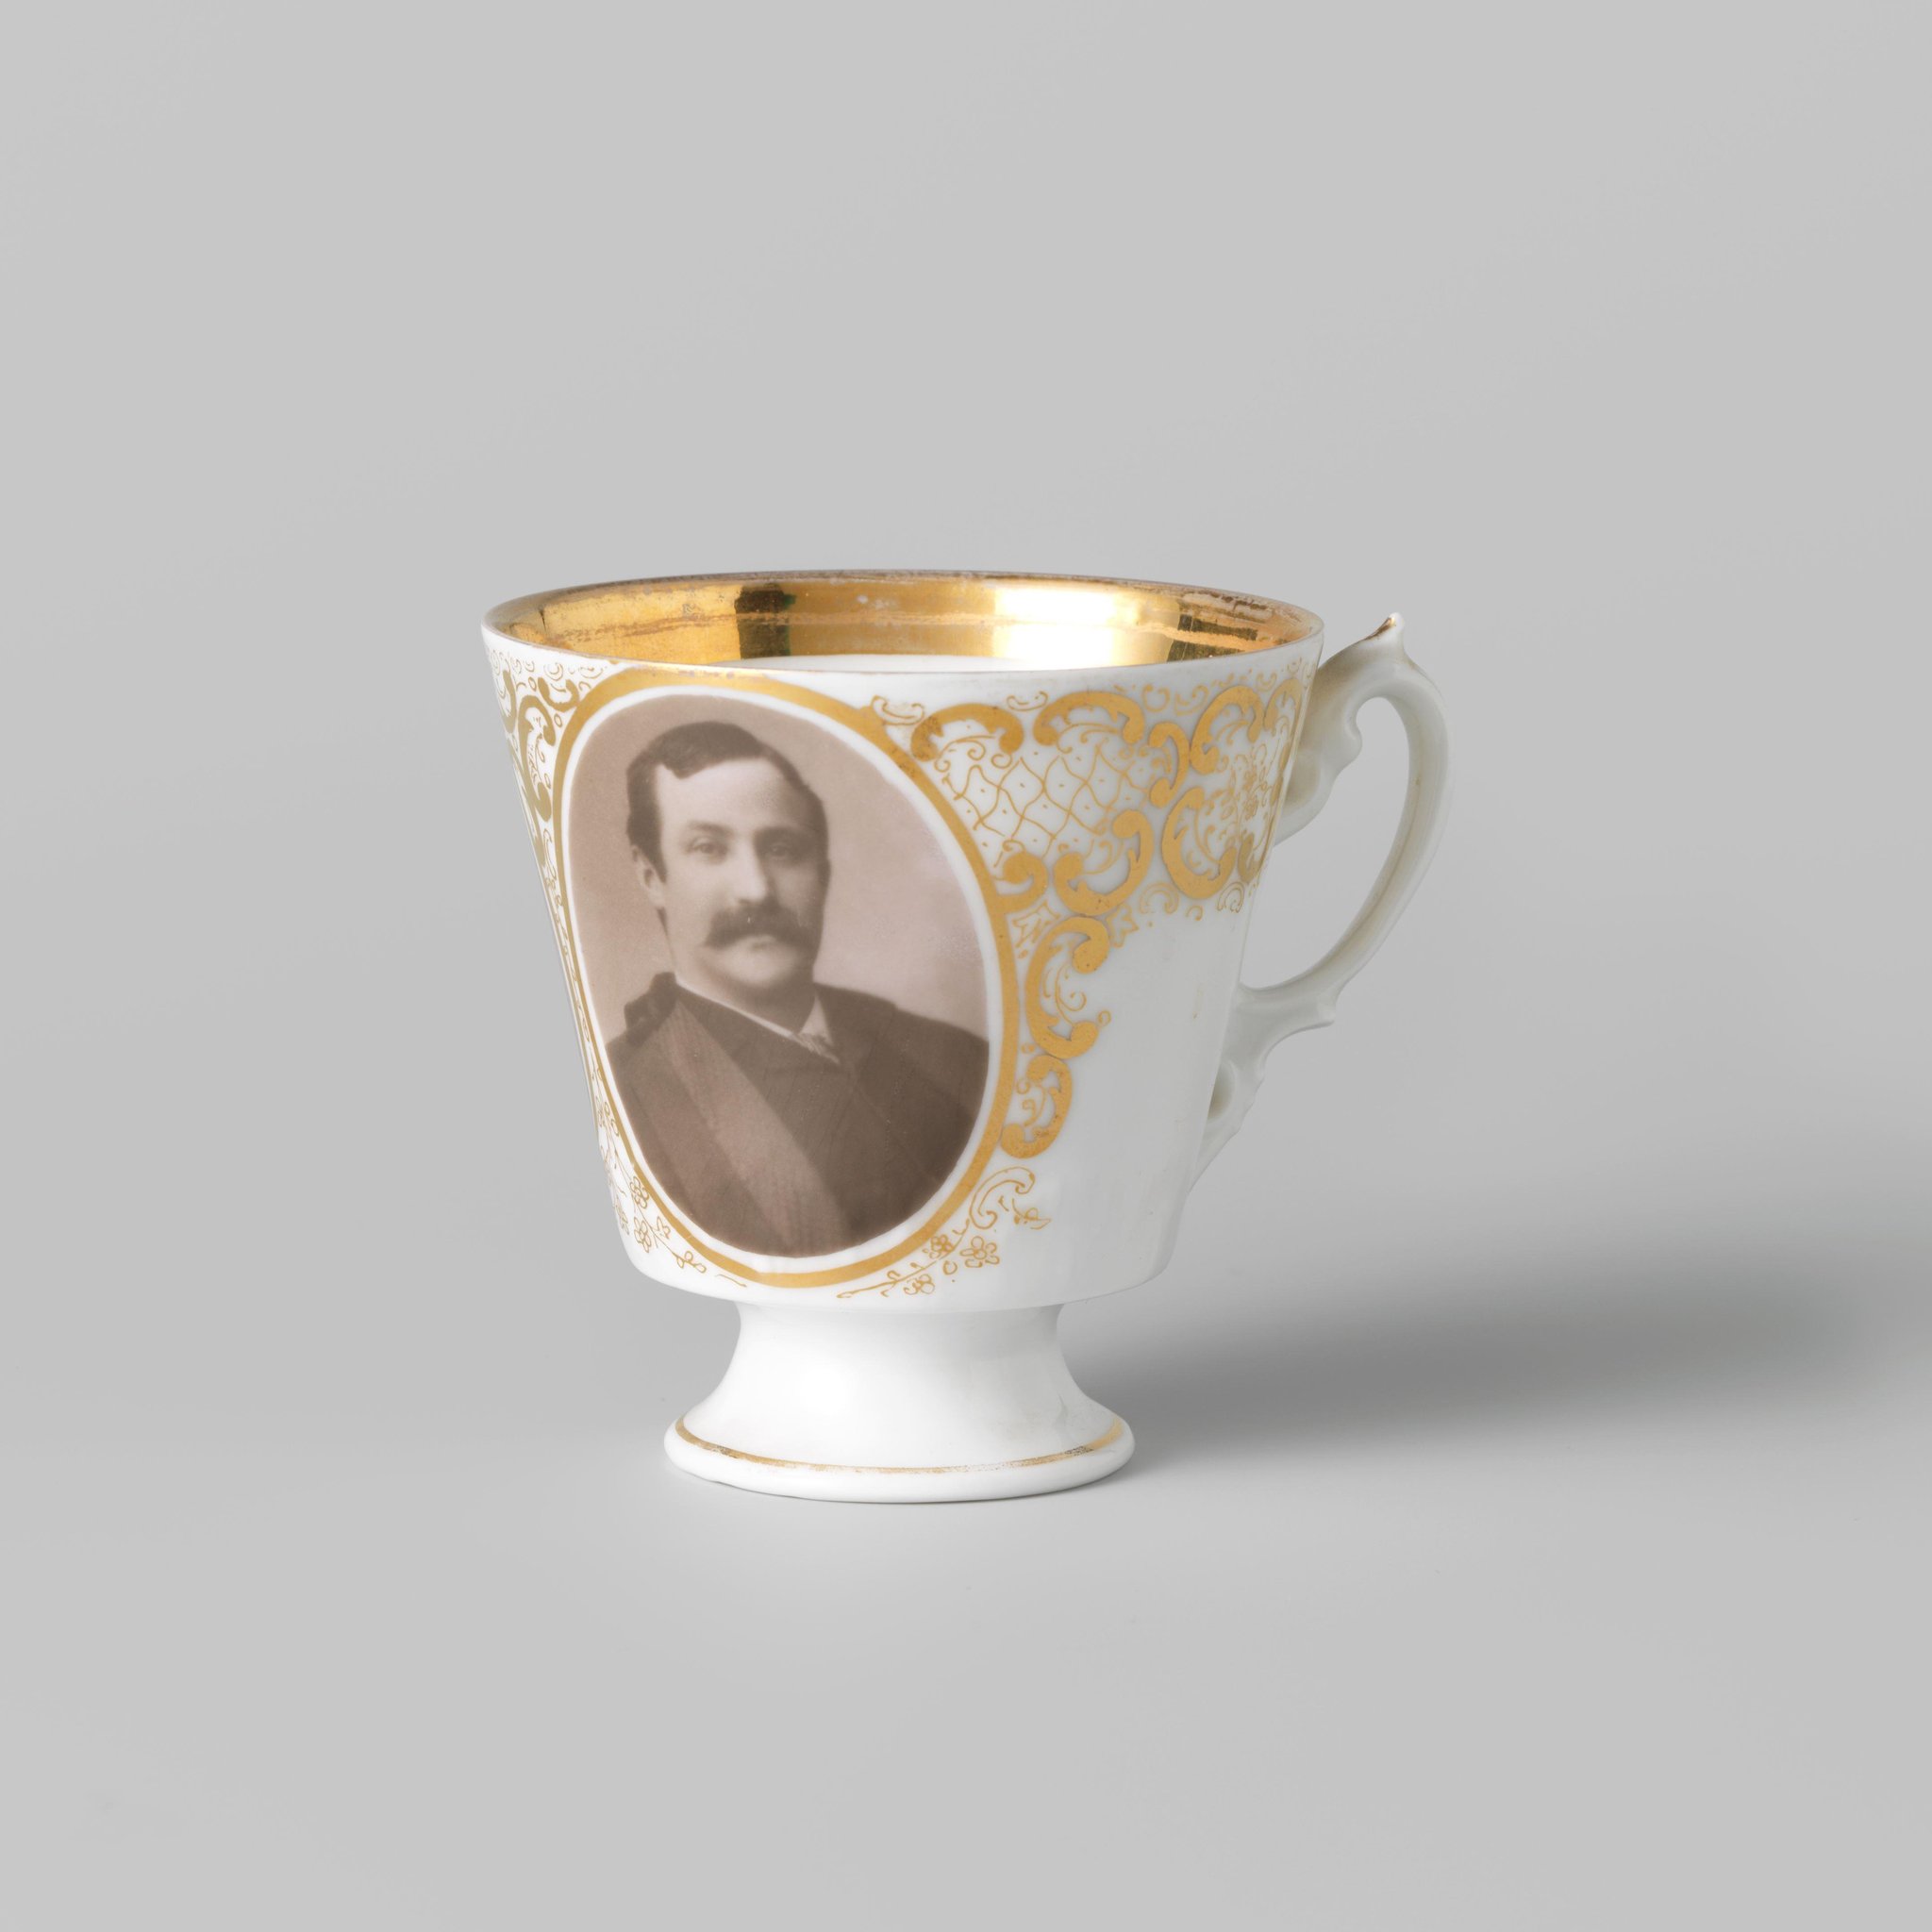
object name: photograph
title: Kop met portretten van een vrouw en een man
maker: Anonymous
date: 1850-1949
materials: ceramic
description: Kop met portretten van een vrouw en een man